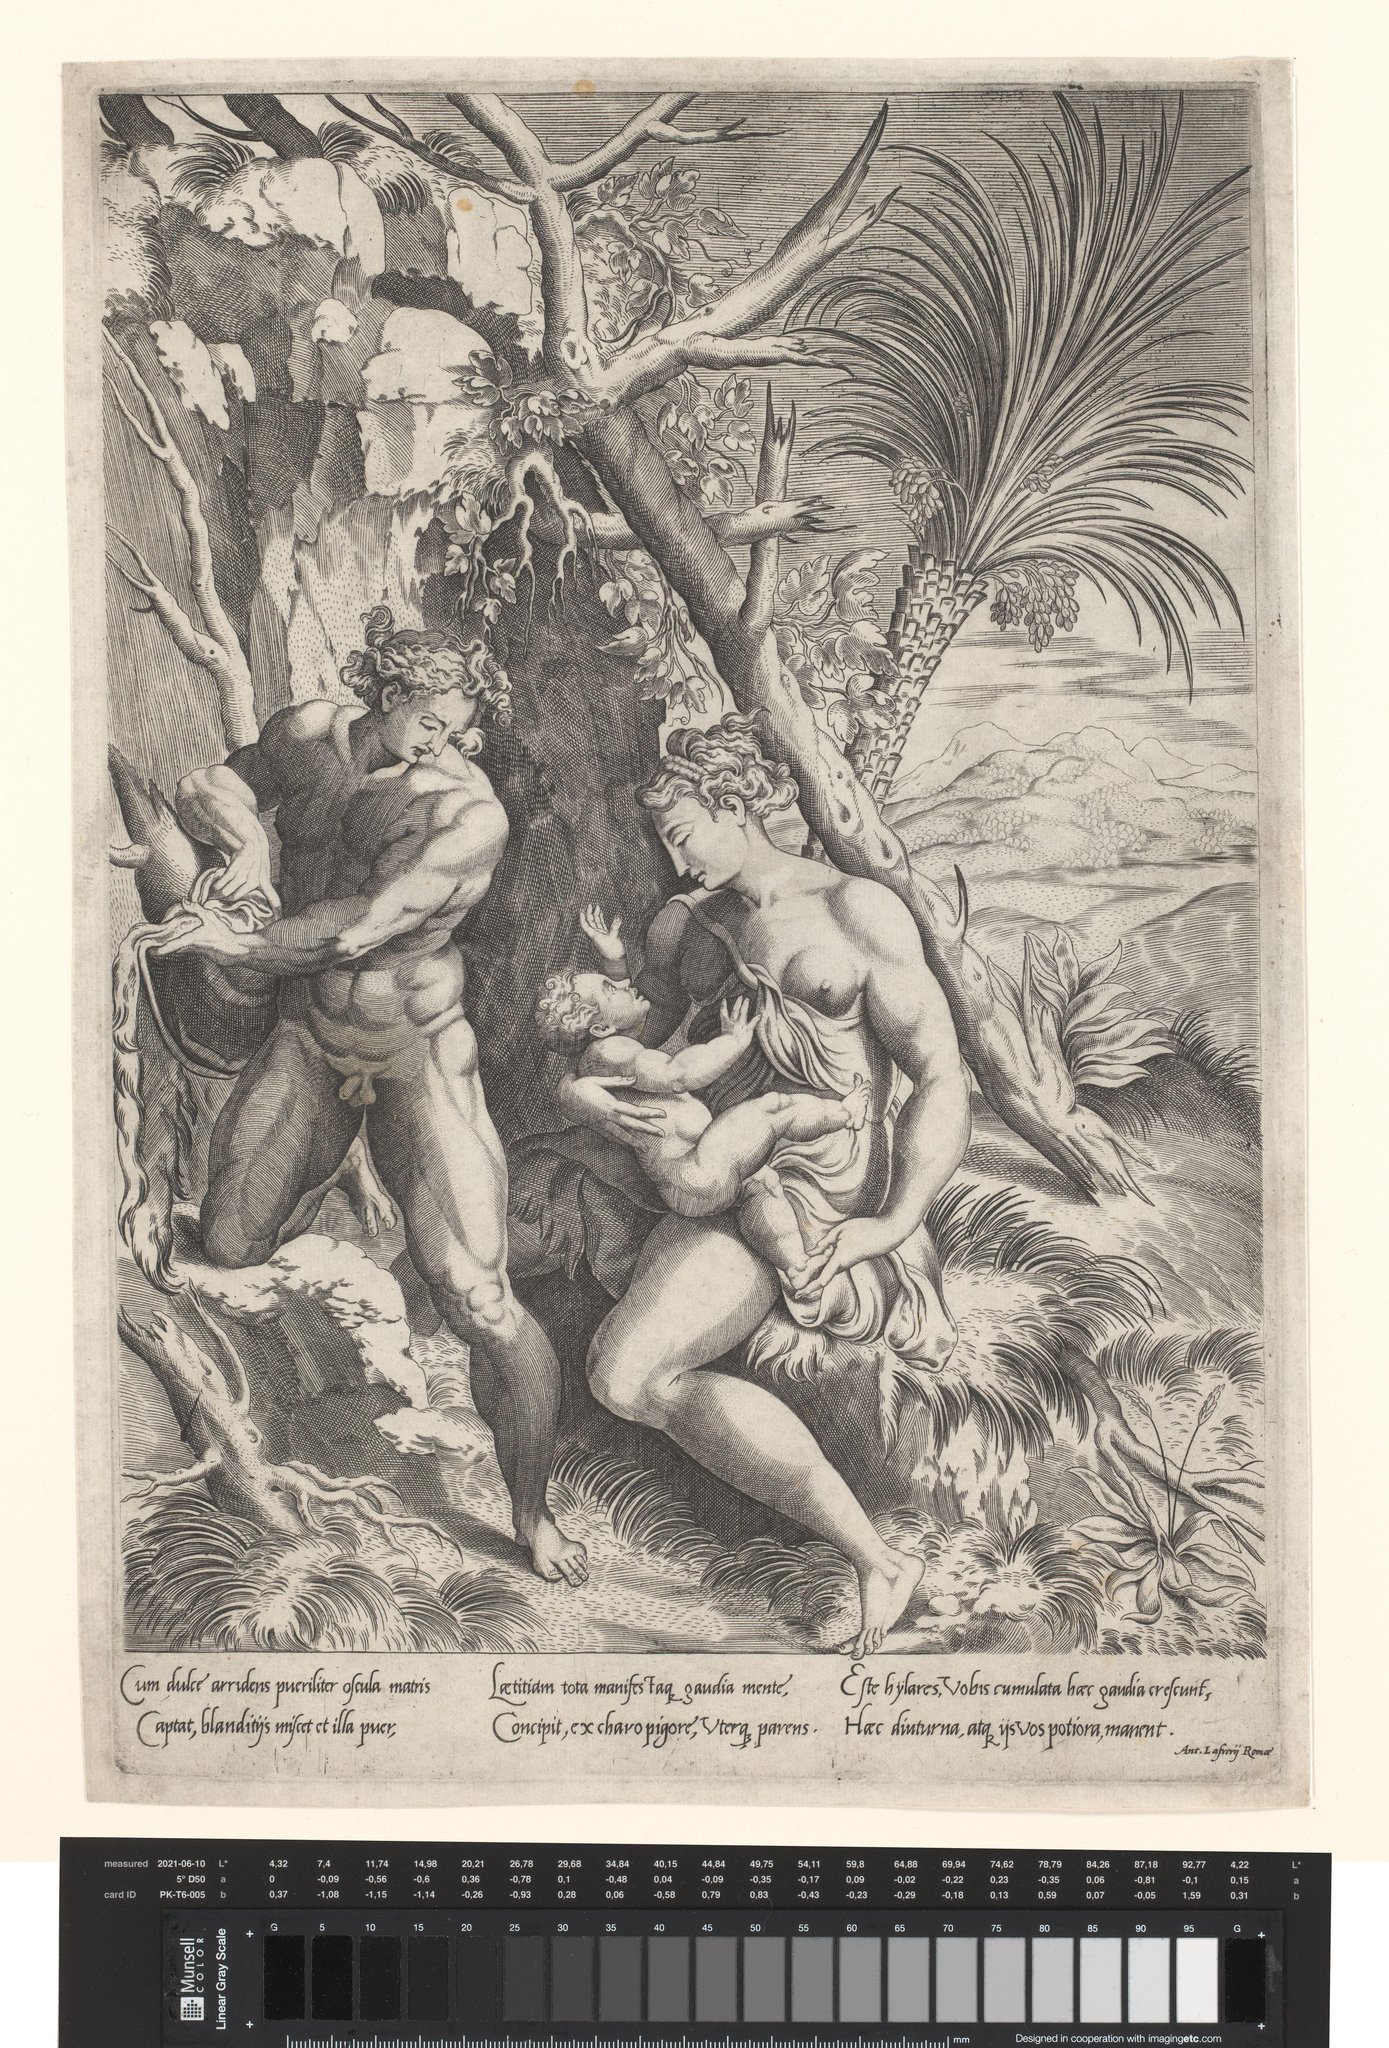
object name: print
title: Adam en Eva als eerste ouders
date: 1560-1574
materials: paper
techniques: engraving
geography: rome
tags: education, upbringing of cain and abel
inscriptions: collector's mark: Lugt 2760, collector's mark: Lugt 2228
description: Adam en Eva zorgend voor Kaïn als baby. Eva zit met Kaïn op schoot; Adam is in de weer met een kleed van dierenhuid. Op de achtergrond een landschap.